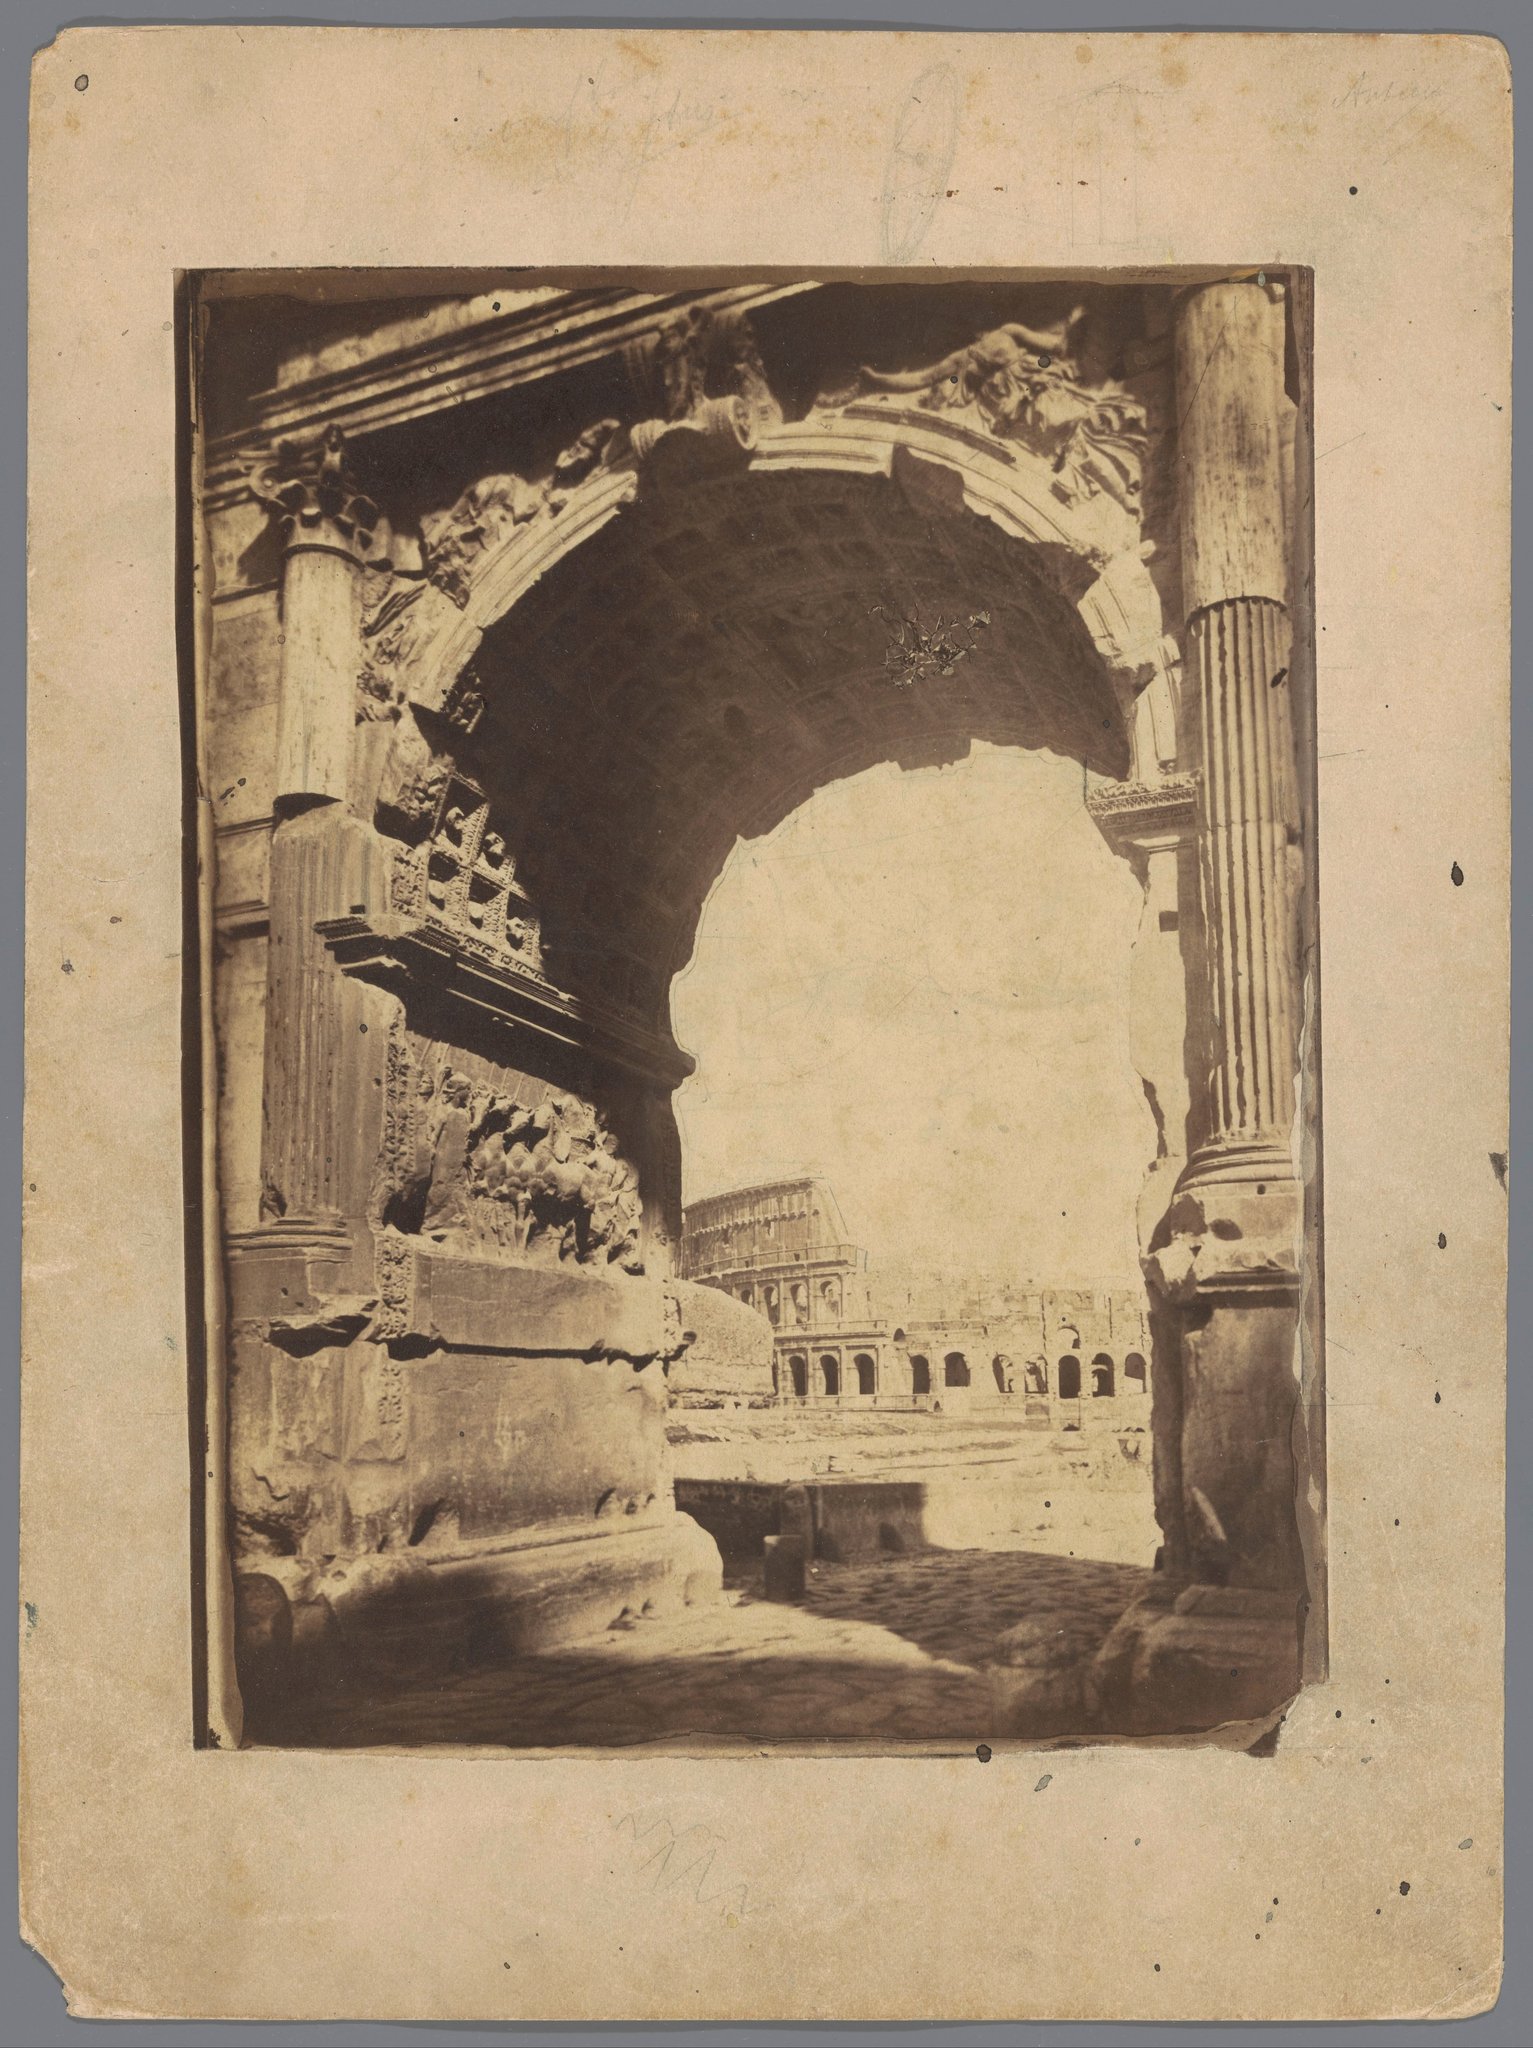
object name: photograph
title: Boog van Titus op het Forum Romanum te Rome, met op de achtergrond het Colosseum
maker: gustave eugène chauffourier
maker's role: fotograaf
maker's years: 1845-1919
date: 1875-1900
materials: photographic support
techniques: albumen print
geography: forum romanum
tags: triumphal arch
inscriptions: collector's mark: Lugt 3937